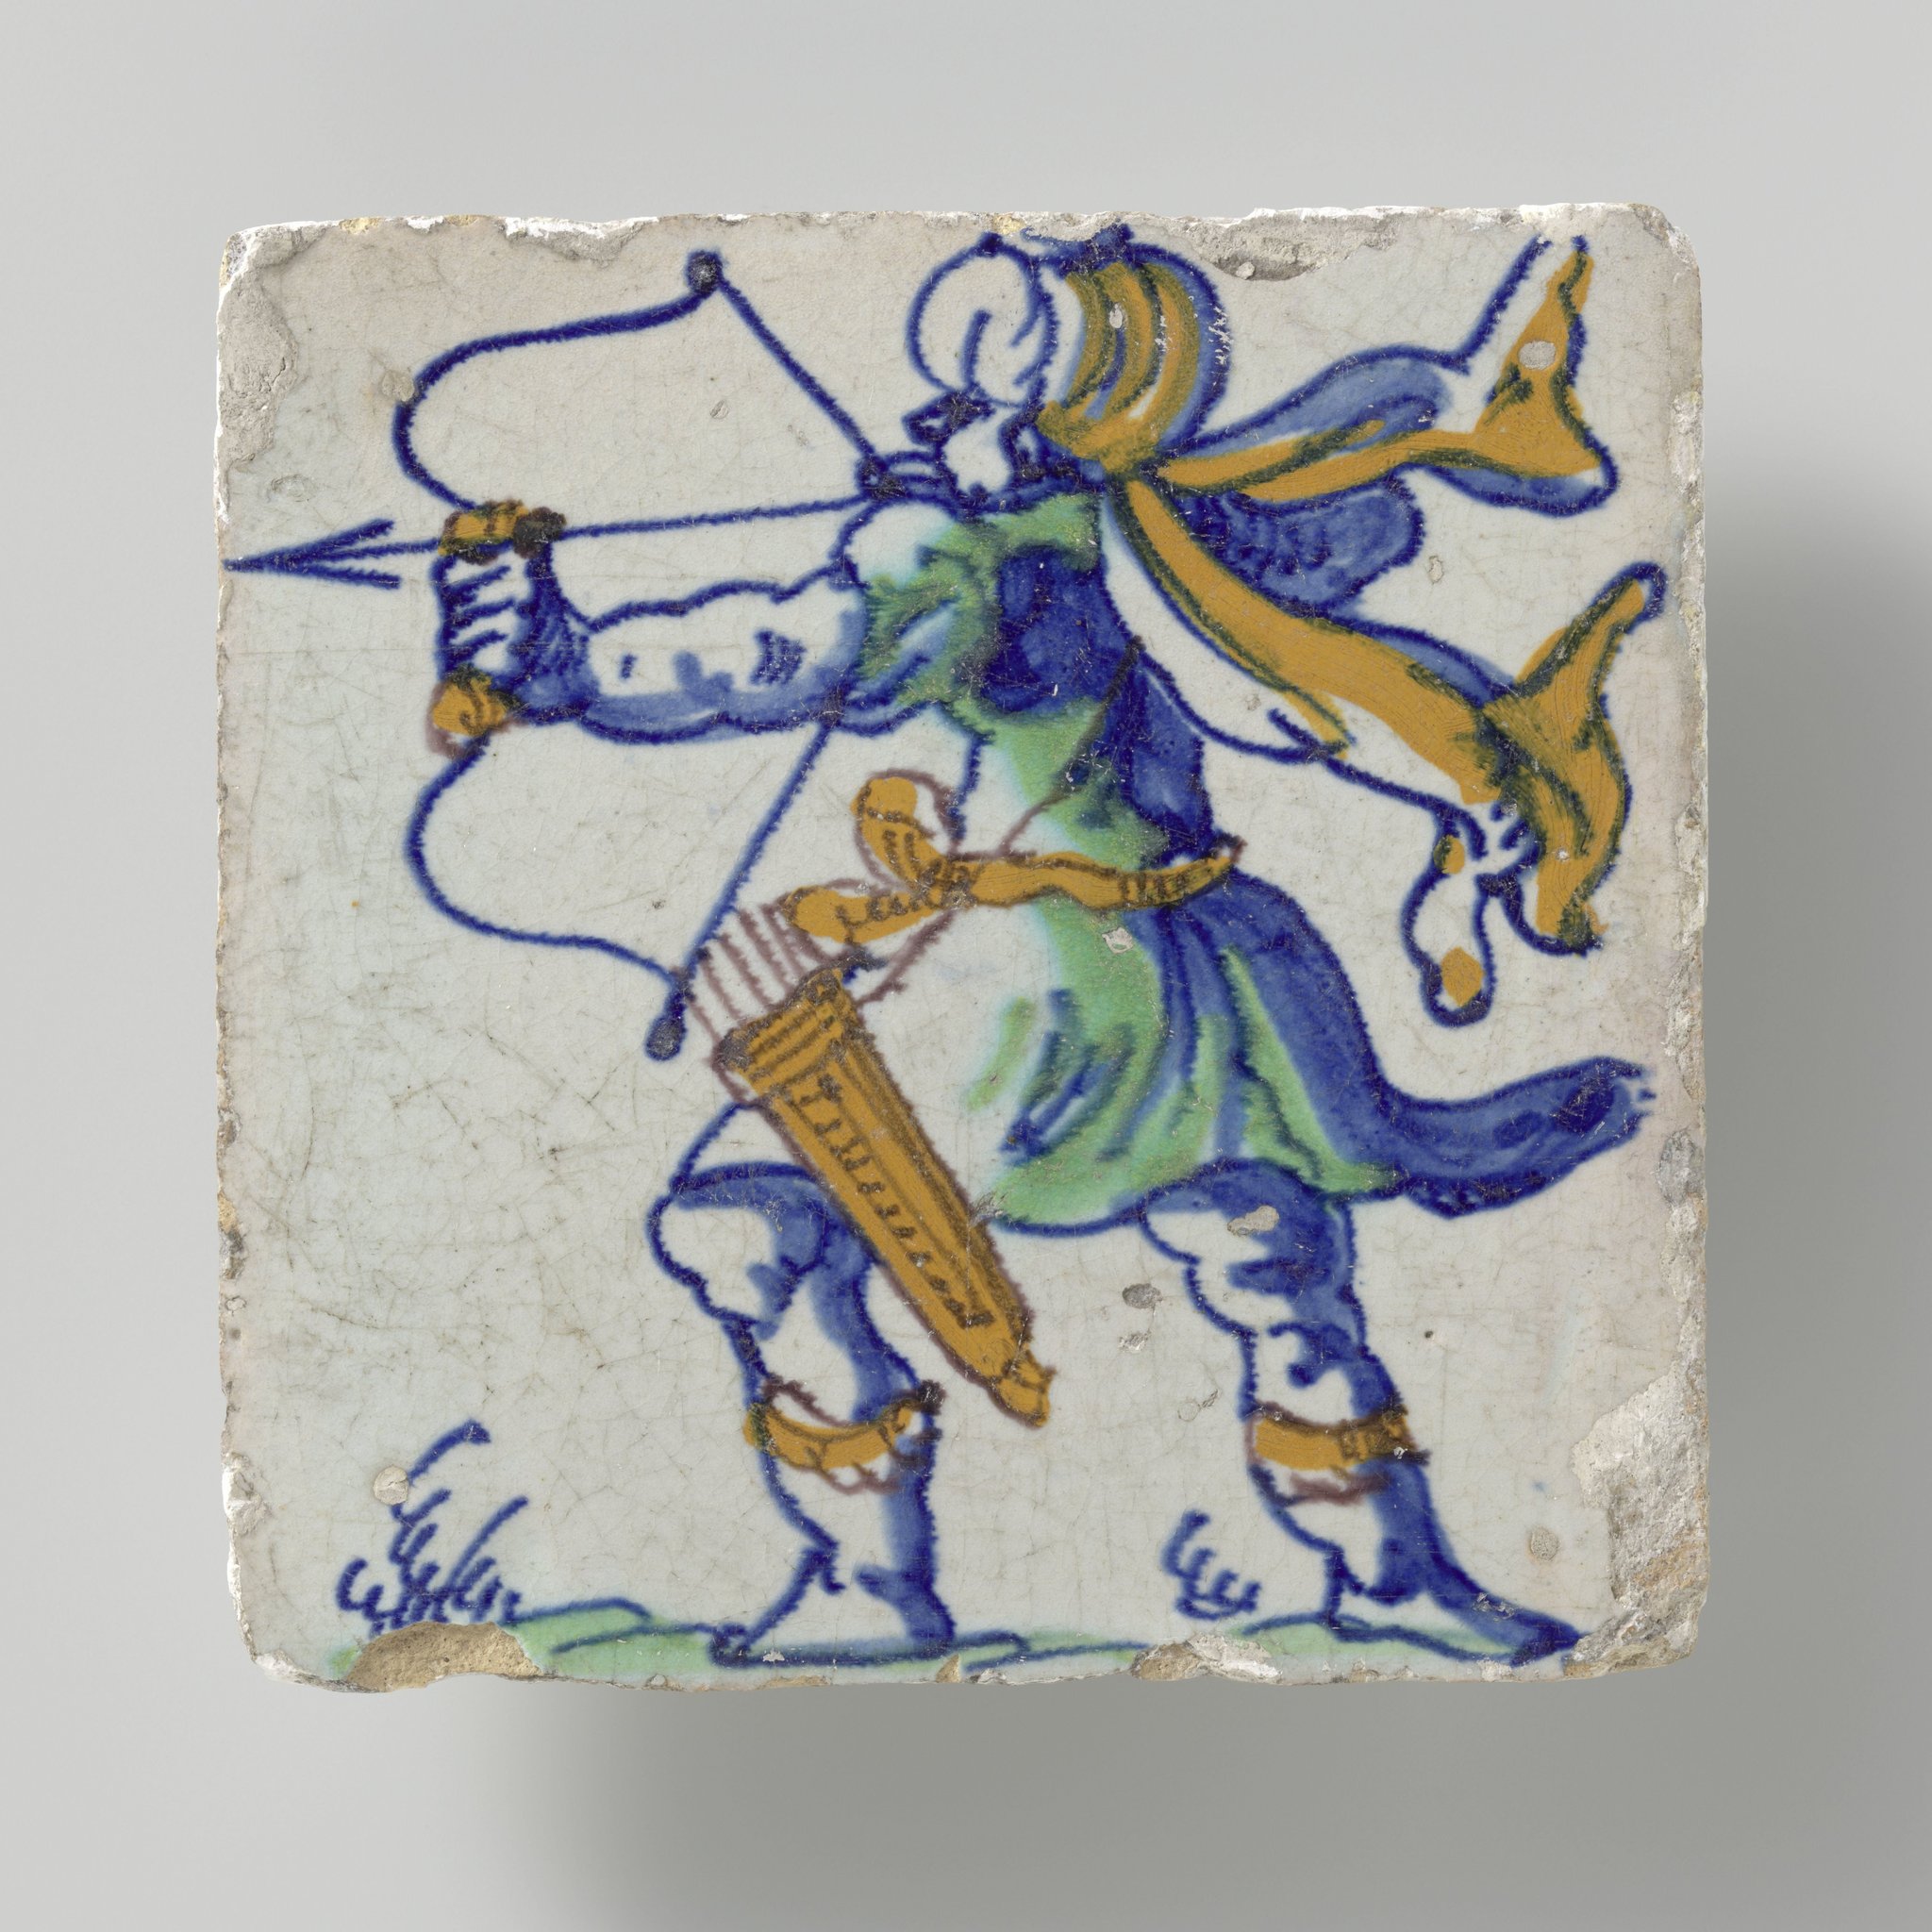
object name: tile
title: Tegel, veelkleurig beschilderd met een Romeinse soldaat of een Saraceense boogschutter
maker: Anonymous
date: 1600-1625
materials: earthenware, glaze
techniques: maiolica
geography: rotterdam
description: Tegel, veelkleurig beschilderd met een Romeinse soldaat of een Saraceense boogschutter.